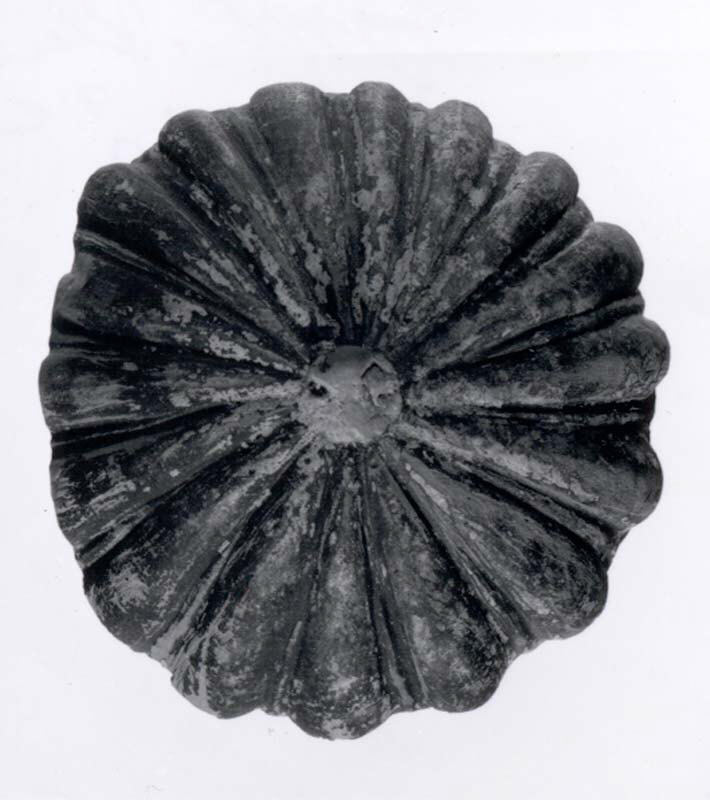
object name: ornament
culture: iranian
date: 900-801 BCE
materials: glass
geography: iran